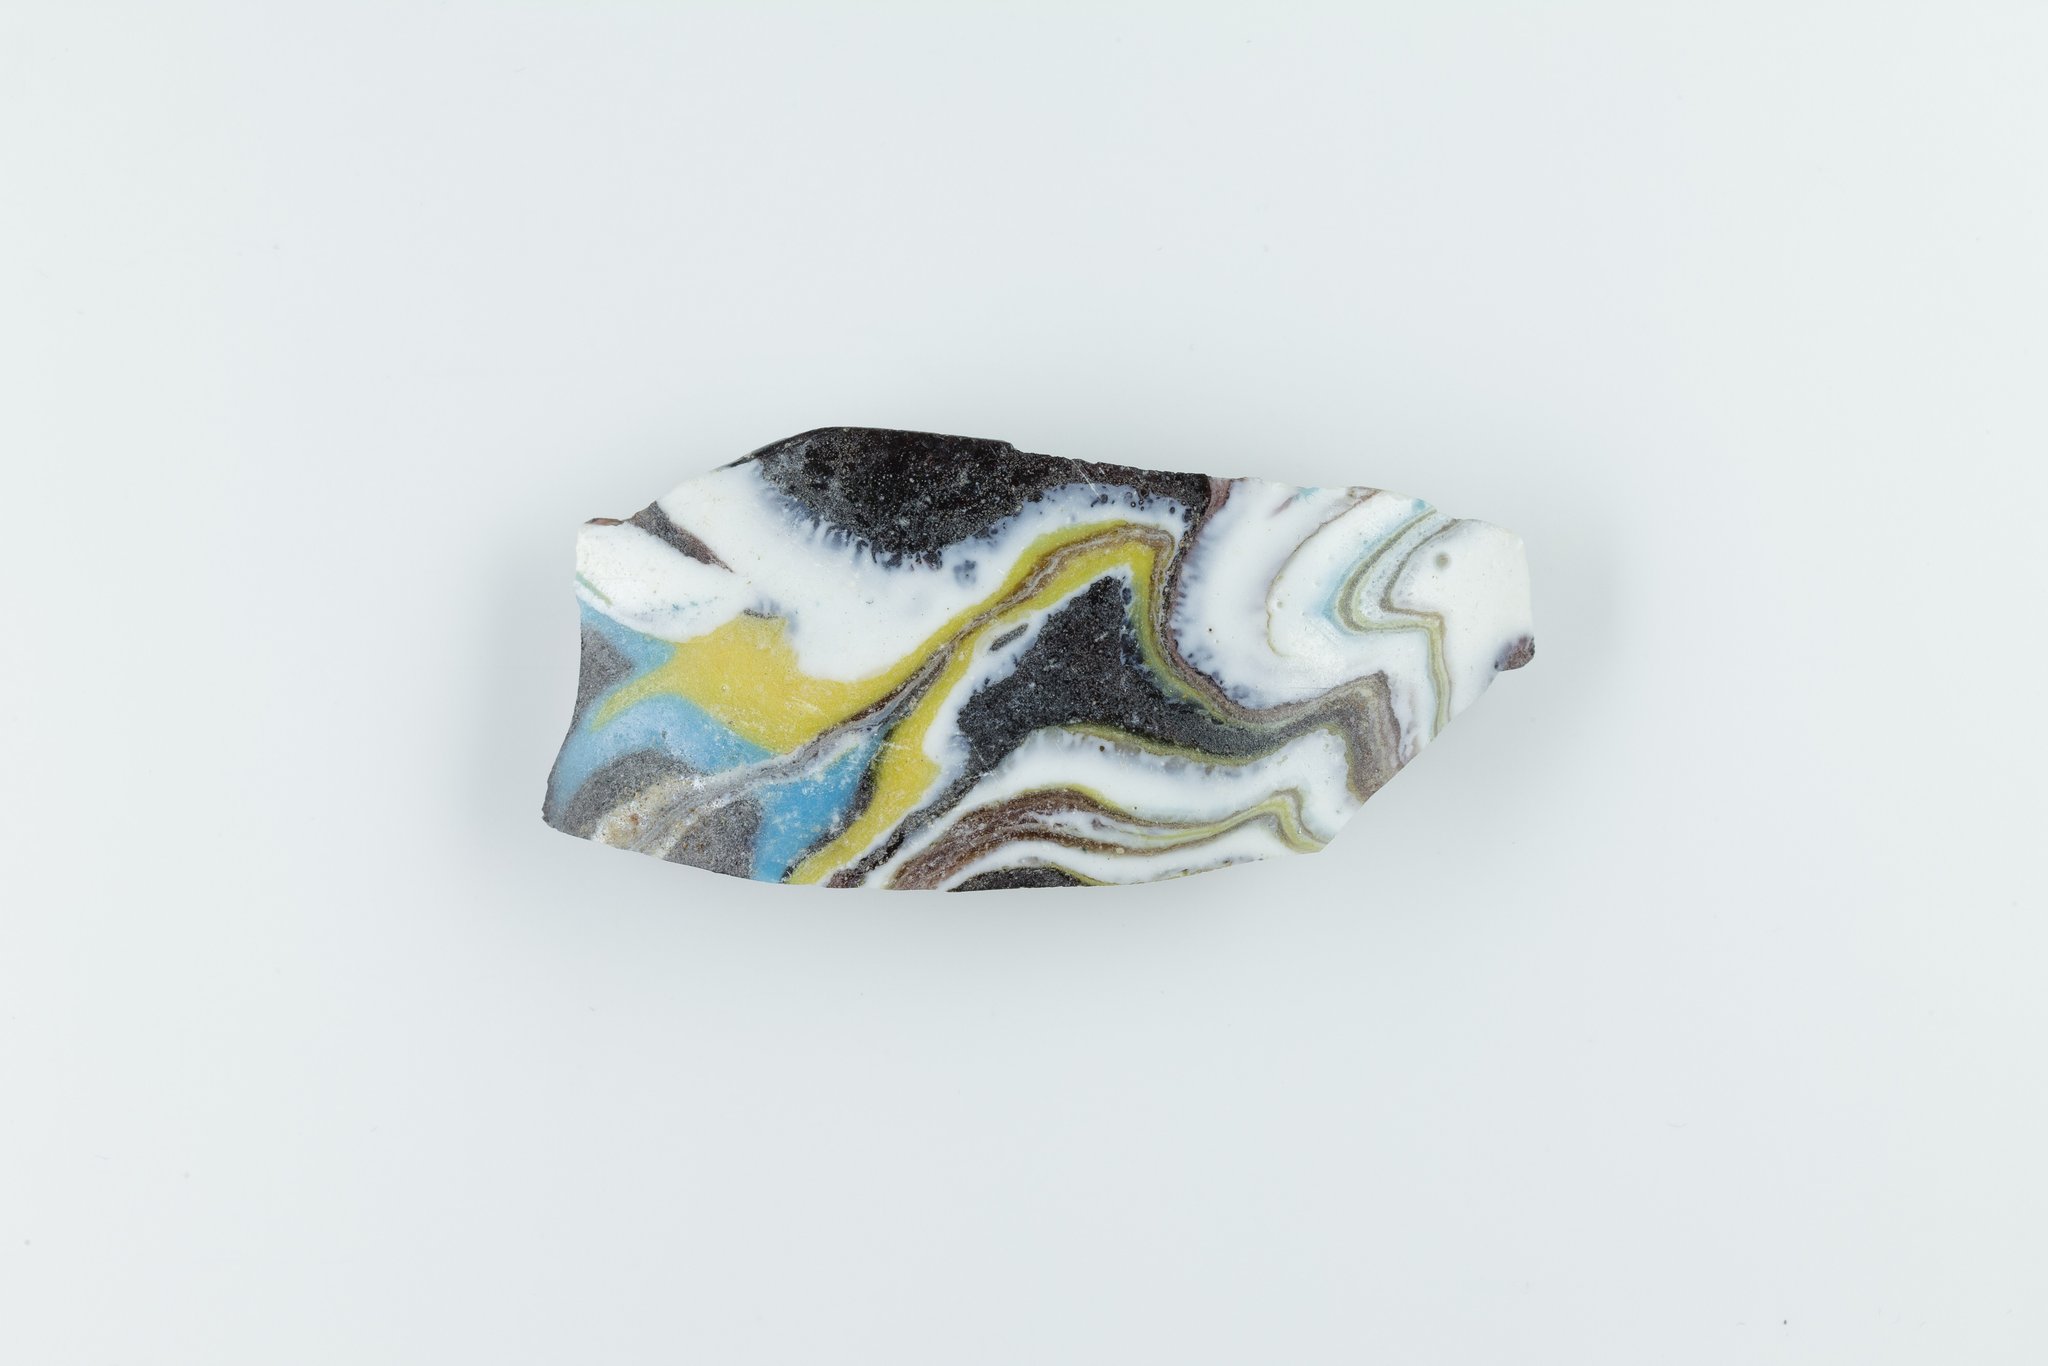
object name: vessel fragment, marbled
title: Fragment from Thick Walled Marbled Vessel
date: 1427-1400 BCE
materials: glass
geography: egypt